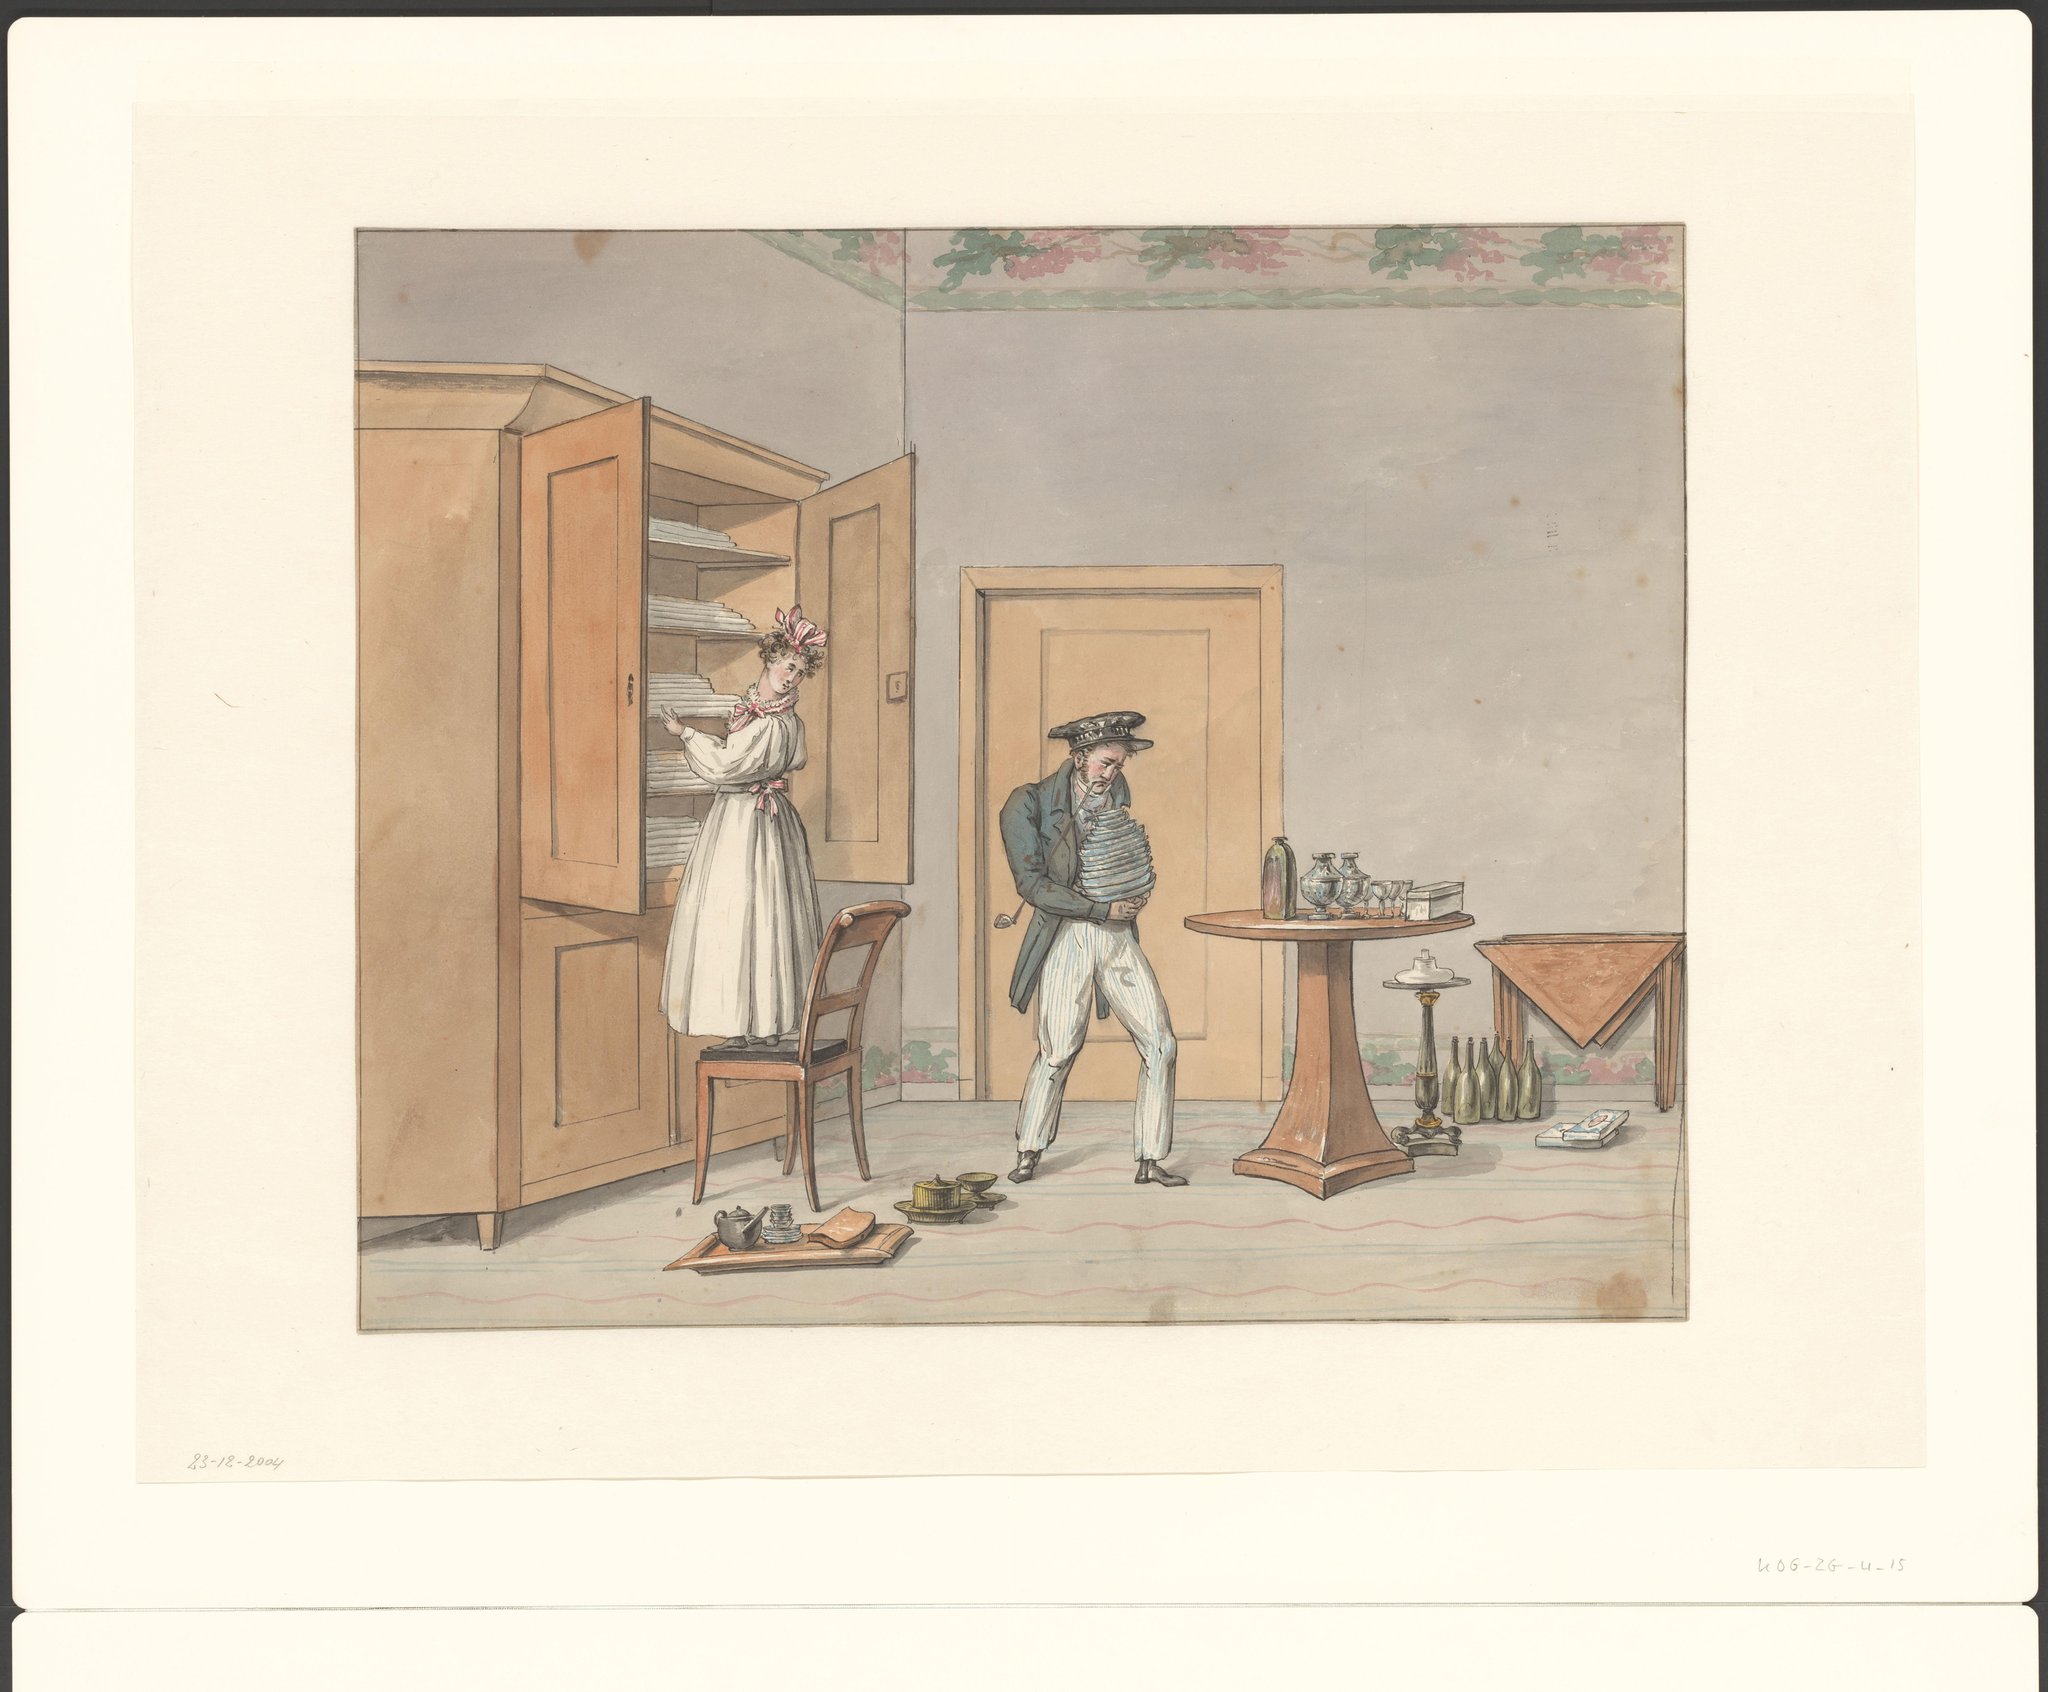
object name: drawing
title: Interieur met een man met een stapel borden en een vrouw bij een linnenkast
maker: jacob willemz. de vos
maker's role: draughtsman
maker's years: 1774-1844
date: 1829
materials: ink, paper, watercolor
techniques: brush, pen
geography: netherlands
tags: family life at home, dinner-service, household chores, cupboard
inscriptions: collector's mark: Lugt 1641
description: In een kamer staat links een geopende linnenkast. Voor de kast staat een vrouw met grote strik in het haar op een stoel. Zij kijkt om naar een man met een pet op zijn hoofd en een lange pijp in zijn mond die een stapel borden draagt. Op een ronde tafel en op de grond staat allerlei serviesgoed en een aantal wijnflessen. Tegen de muur staan twee opgeklapte tafels. De tekening lijkt onderdeel te zijn van een serie bestaande uit de nummers KOG-ZG-4-14 tot en met KOG-ZG-4-18.